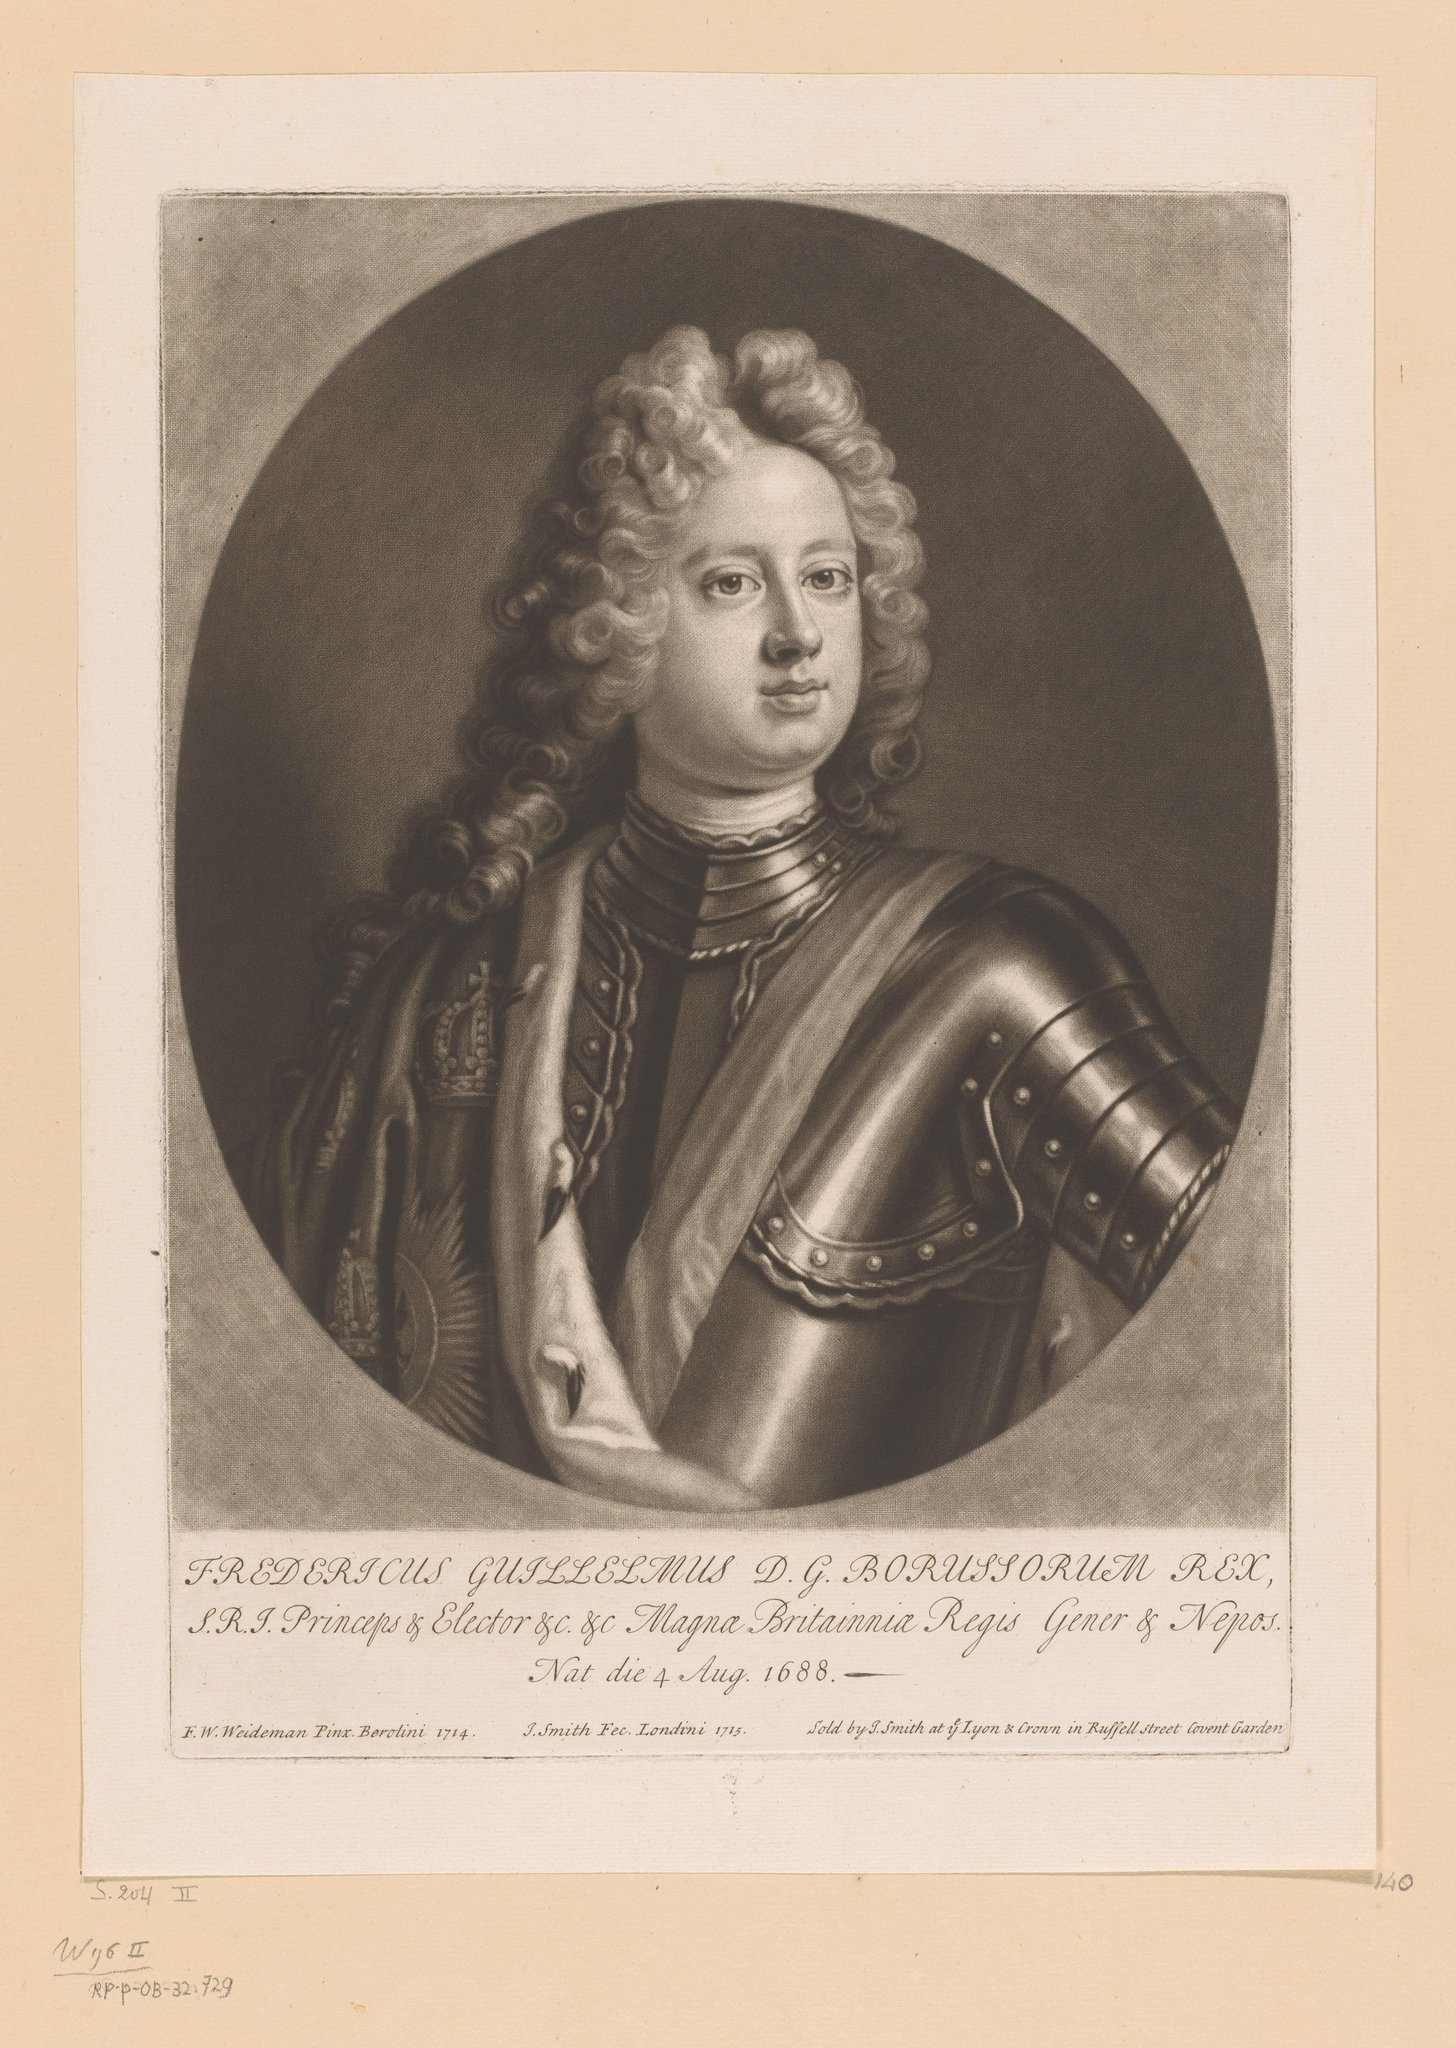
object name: print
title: Portret van Frederik Willem I, koning van Pruisen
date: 1714-1715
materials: paper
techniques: mezzotint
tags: berlin, historical persons, king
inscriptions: collector's mark: Lugt 240